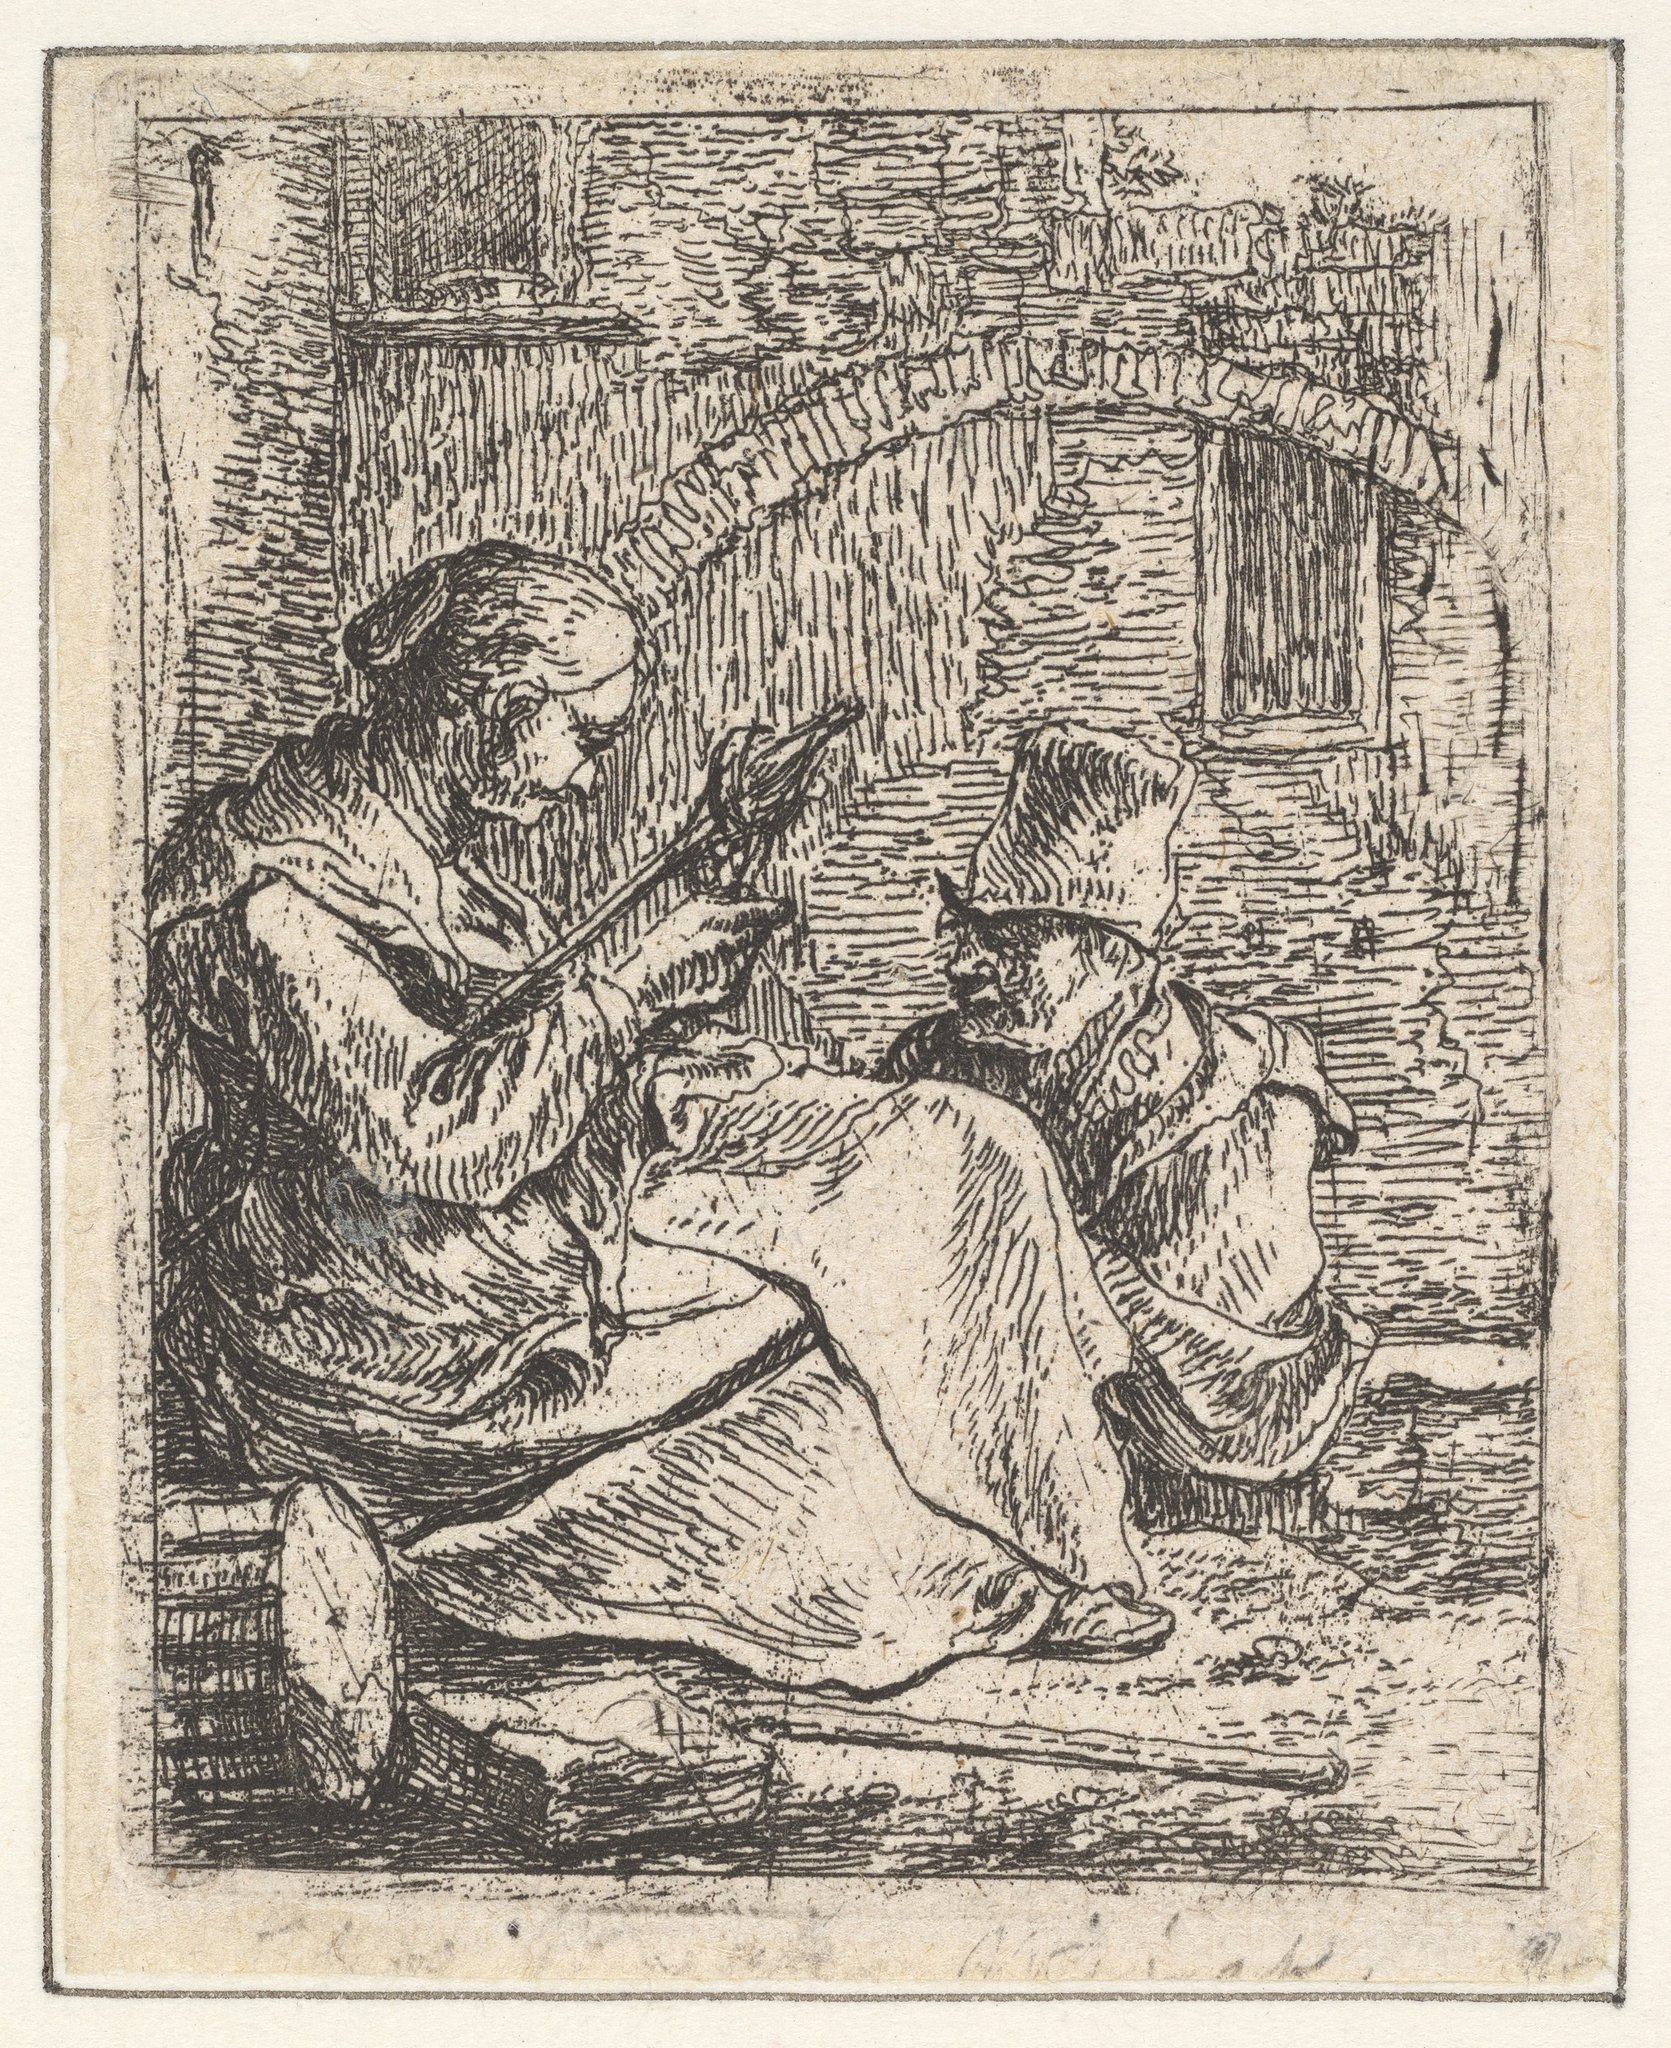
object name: print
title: Woman Spinning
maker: thomas wijck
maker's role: artist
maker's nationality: dutch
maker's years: 1616-1677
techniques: drypoint, etching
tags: men,women,working